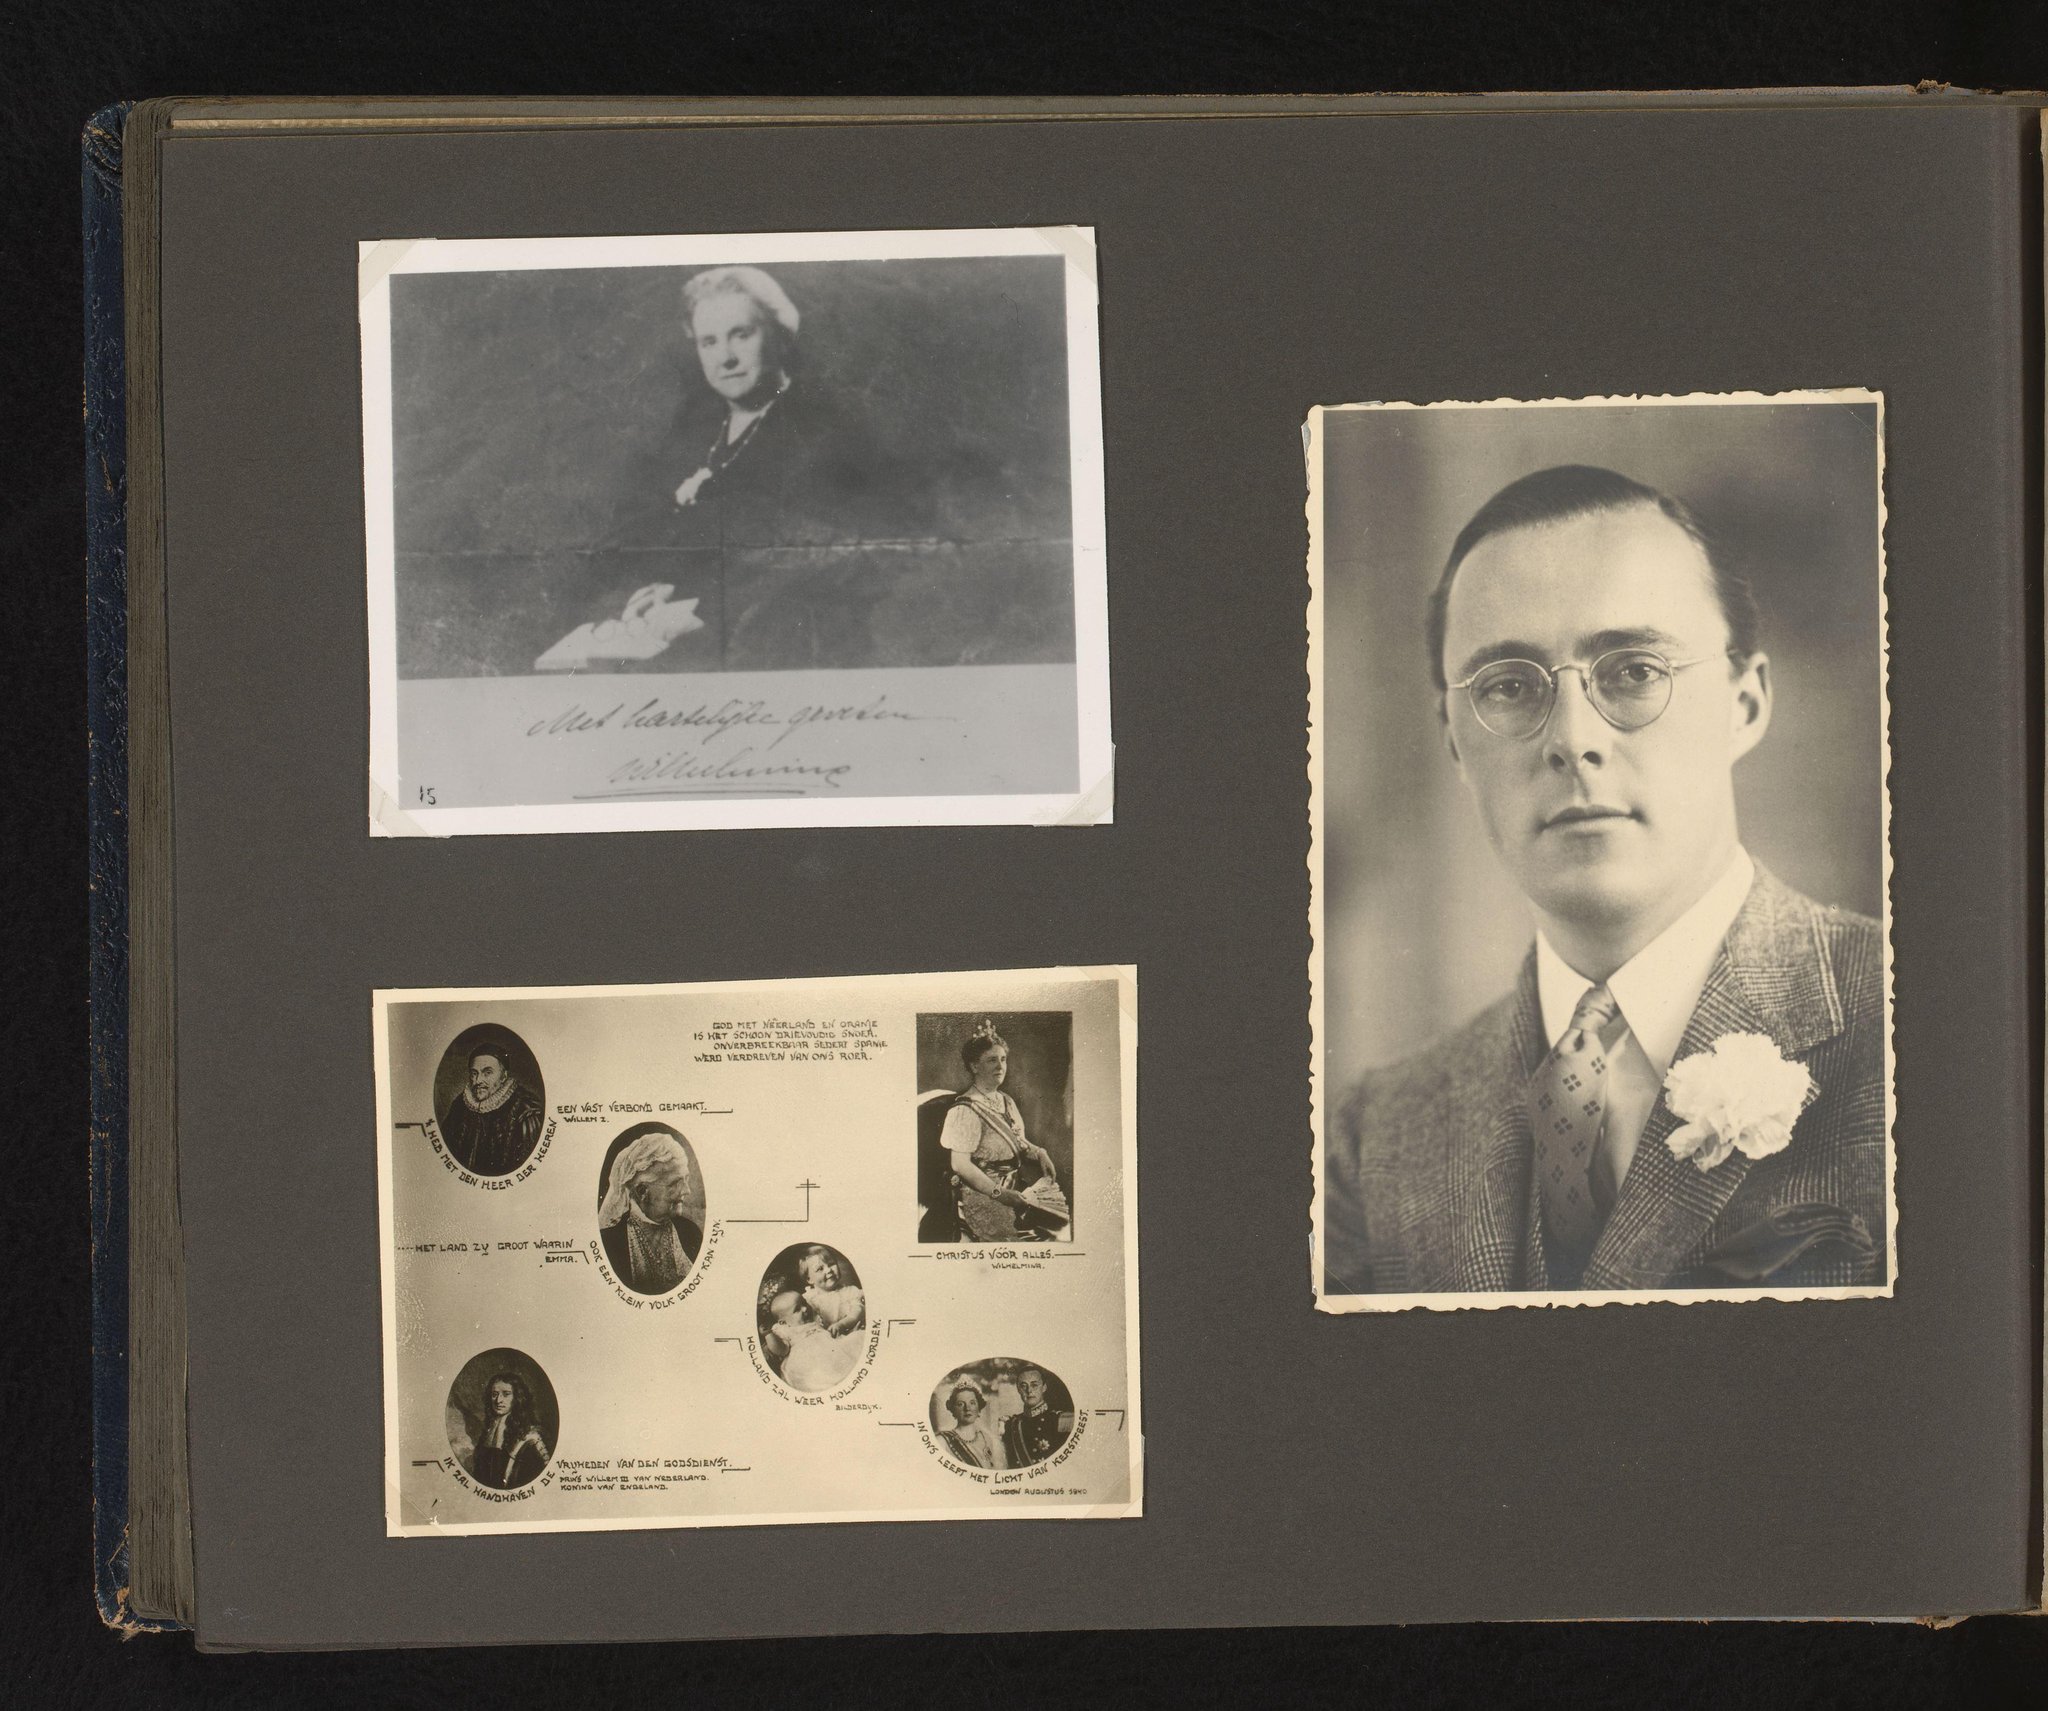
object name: photograph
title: Koningin Wilhelmina, prins Bernhard en stamboom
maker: Anonymous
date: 1940-1945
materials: cardboard, photographic support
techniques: gelatin silver print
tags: the hague, print maker, wilhelmina of the netherlands, utrecht, bernhard (prins der nederlanden), parents with their children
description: Albumblad met drie foto's van Koningin Wilhelmina, prins Bernhard en van een document met foto's van de Koninklijke Familie. Onderdeel van fotoalbum over het familieleven van de leden van het Koninklijk Huis tussen 1937-1945.